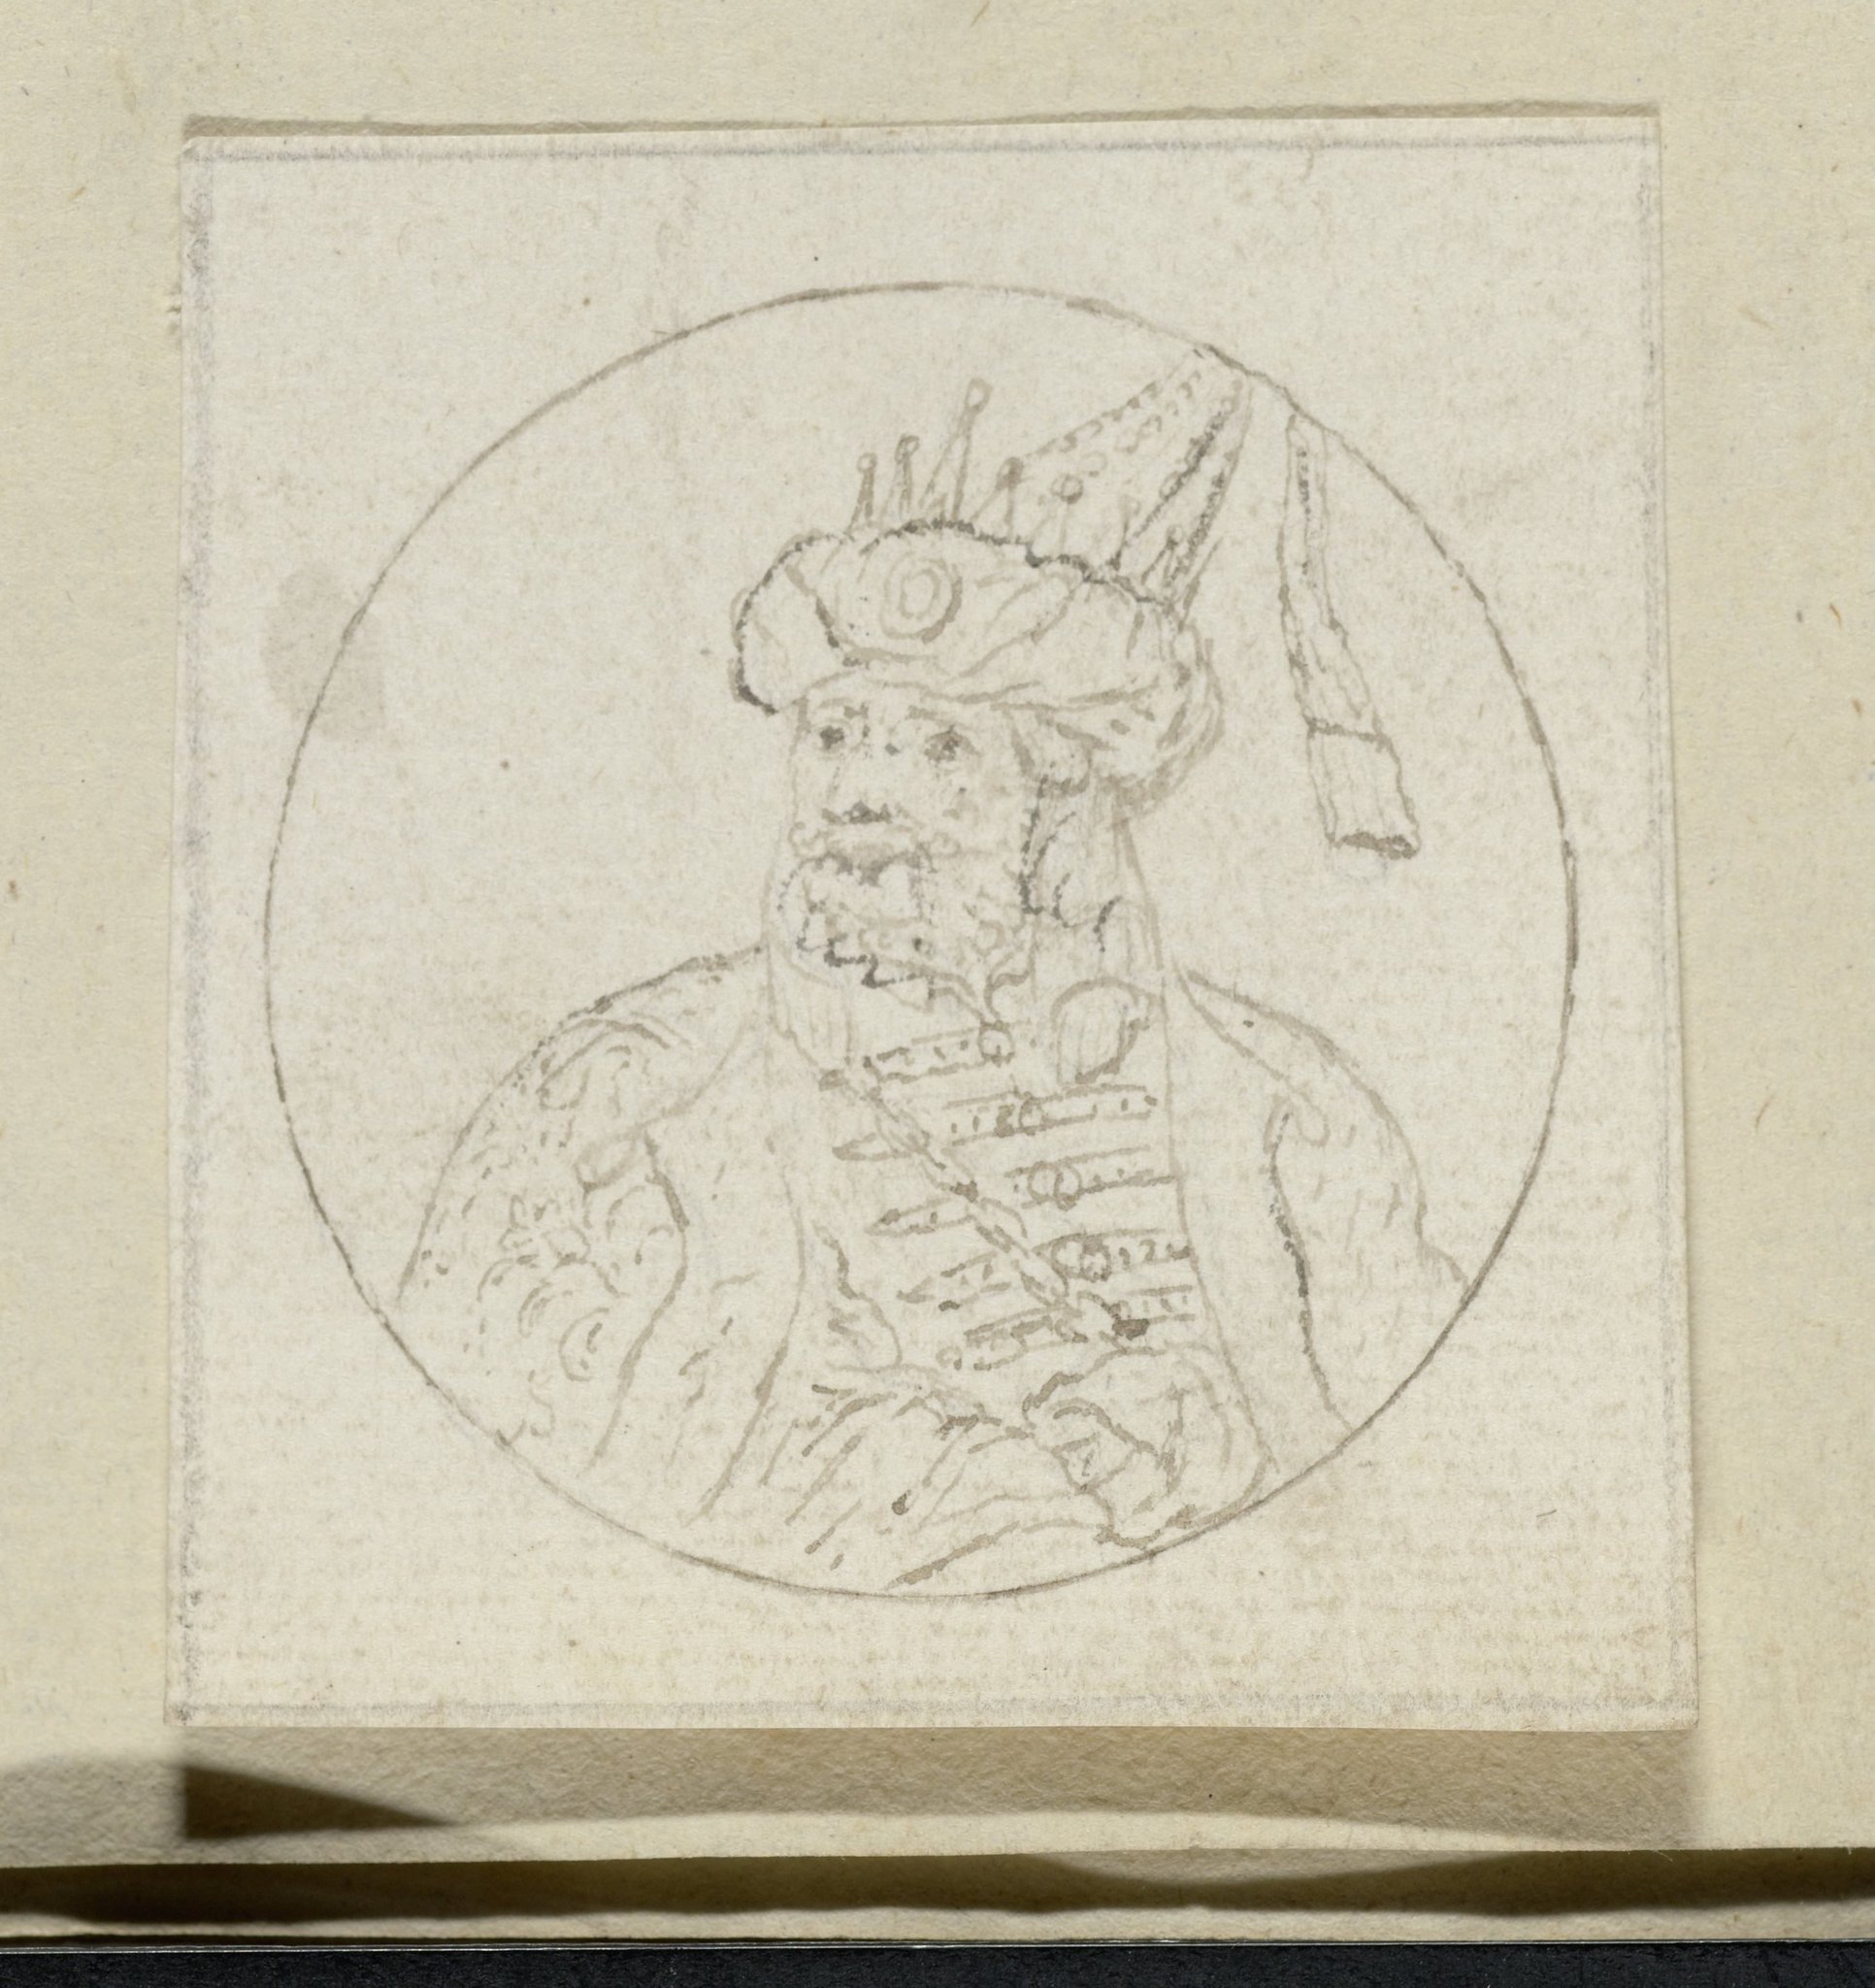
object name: drawing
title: Buste van een man met baard en puntmuts in een cirkel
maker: Anonymous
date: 1700-1799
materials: ink, paper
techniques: pen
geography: netherlands